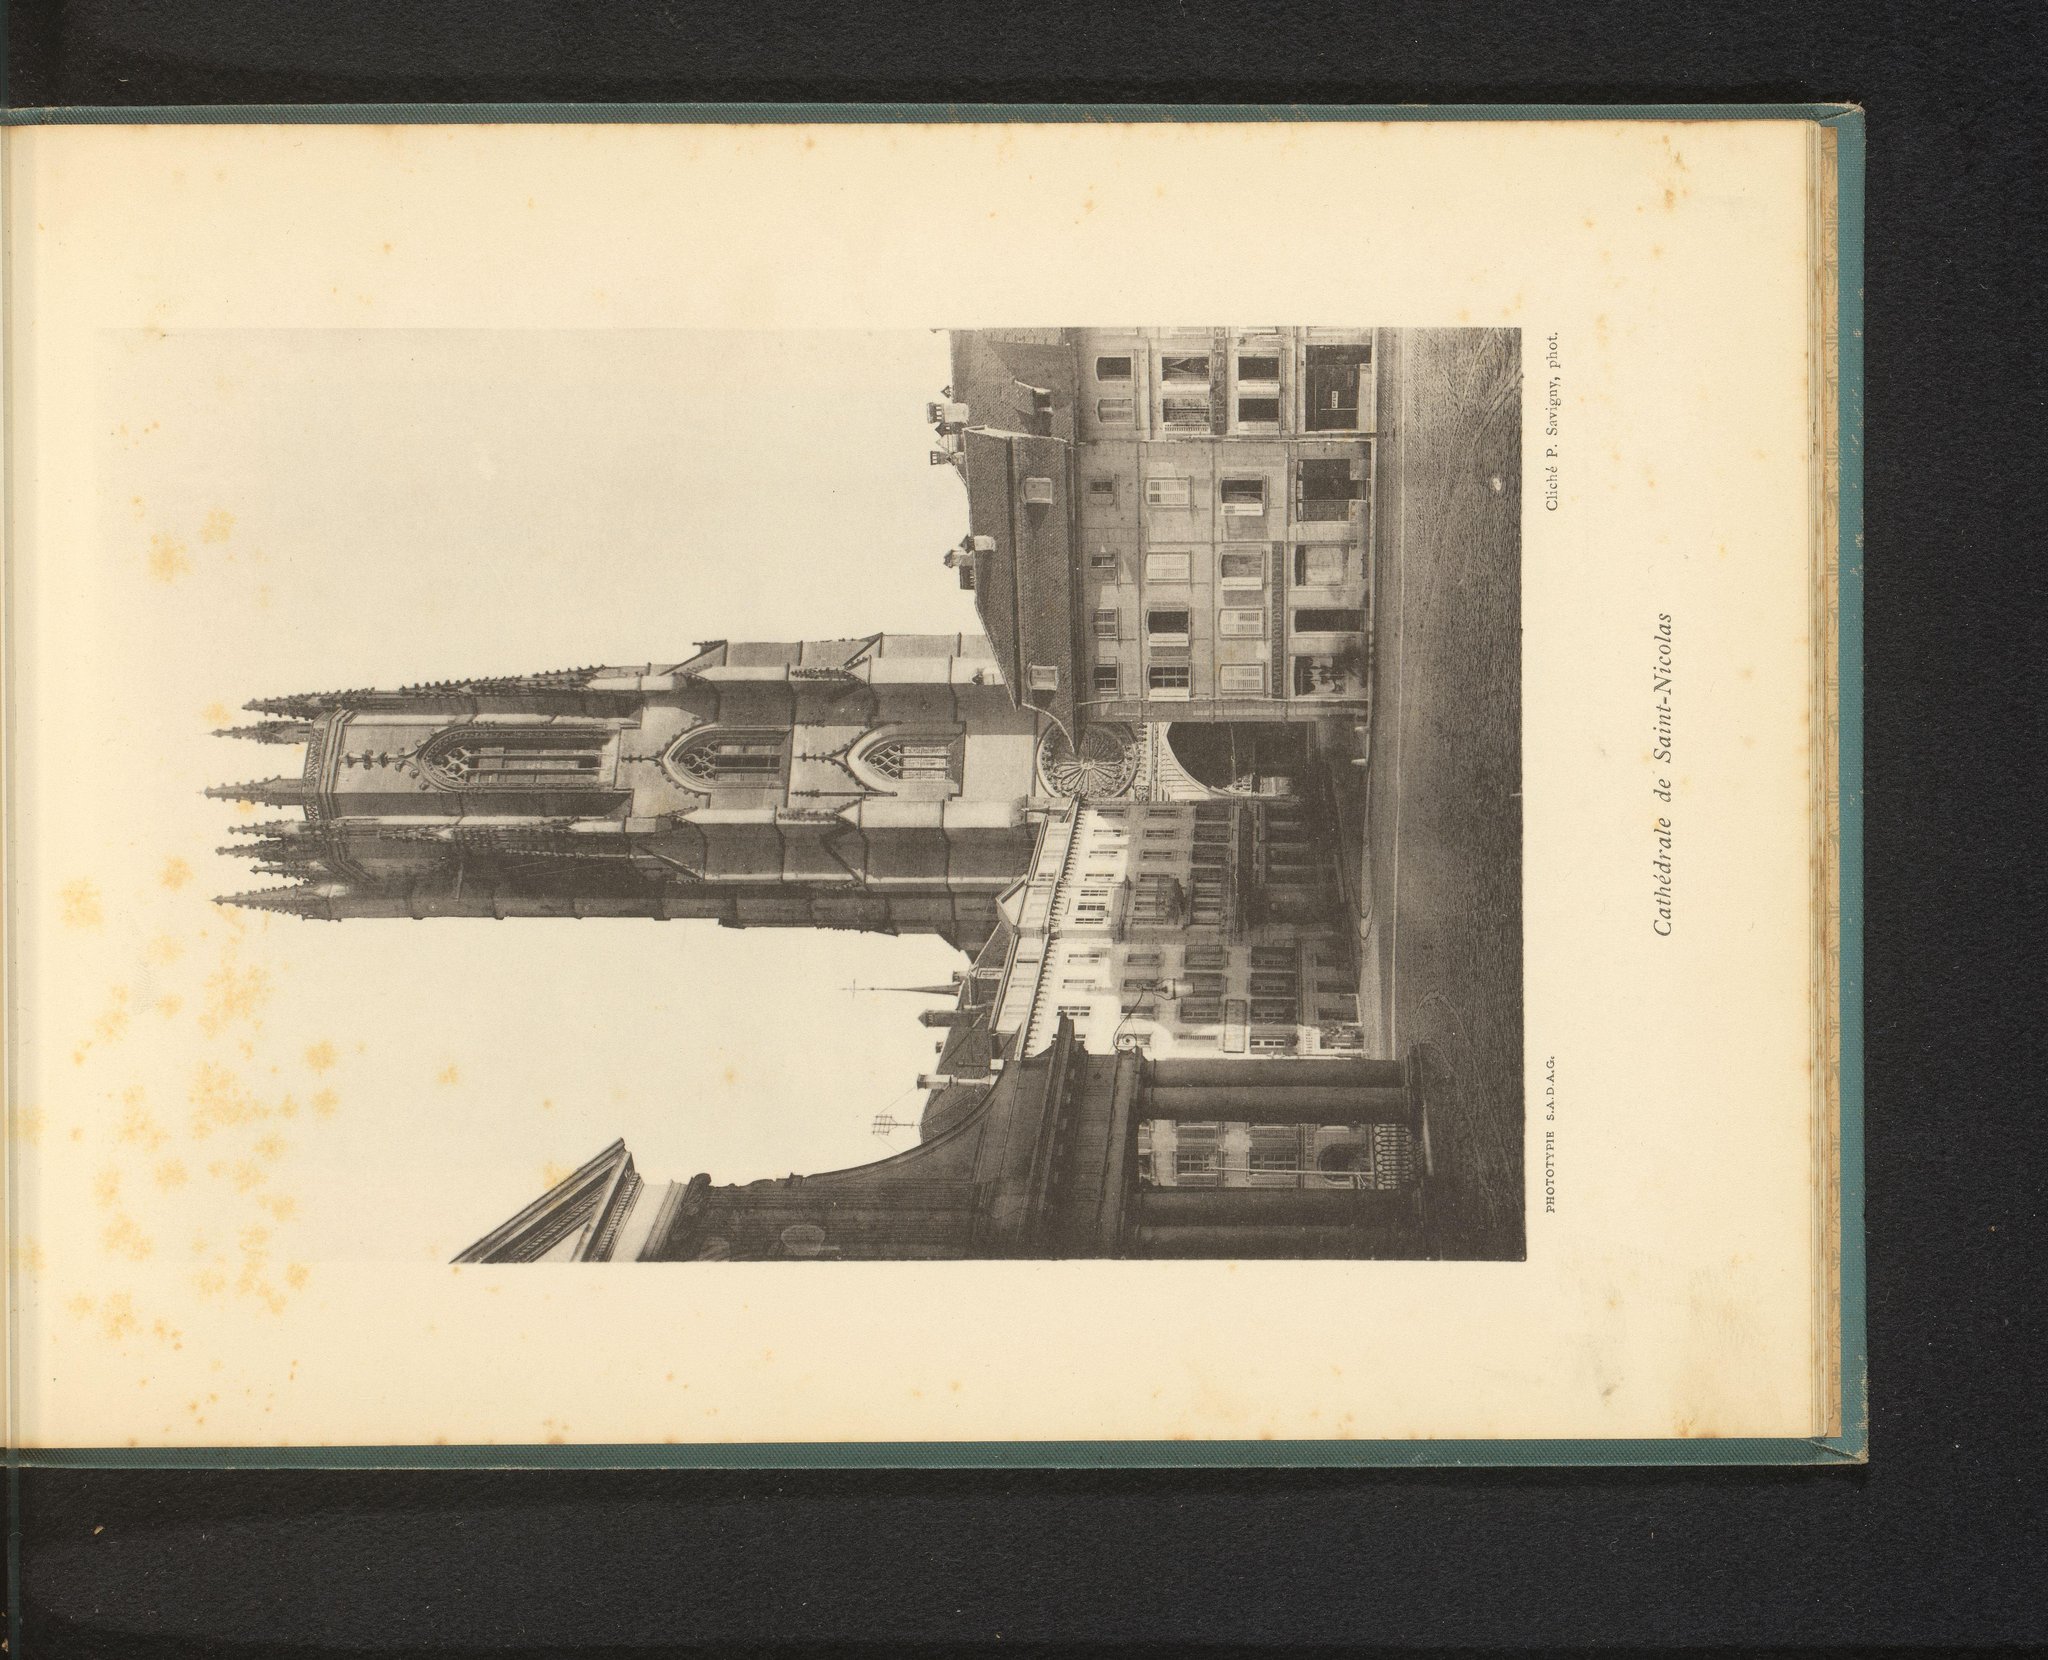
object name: photomechanical print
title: Gezicht op de Kathedraal van Fribourg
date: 1897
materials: paper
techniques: photograph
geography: fribourg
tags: church (exterior)